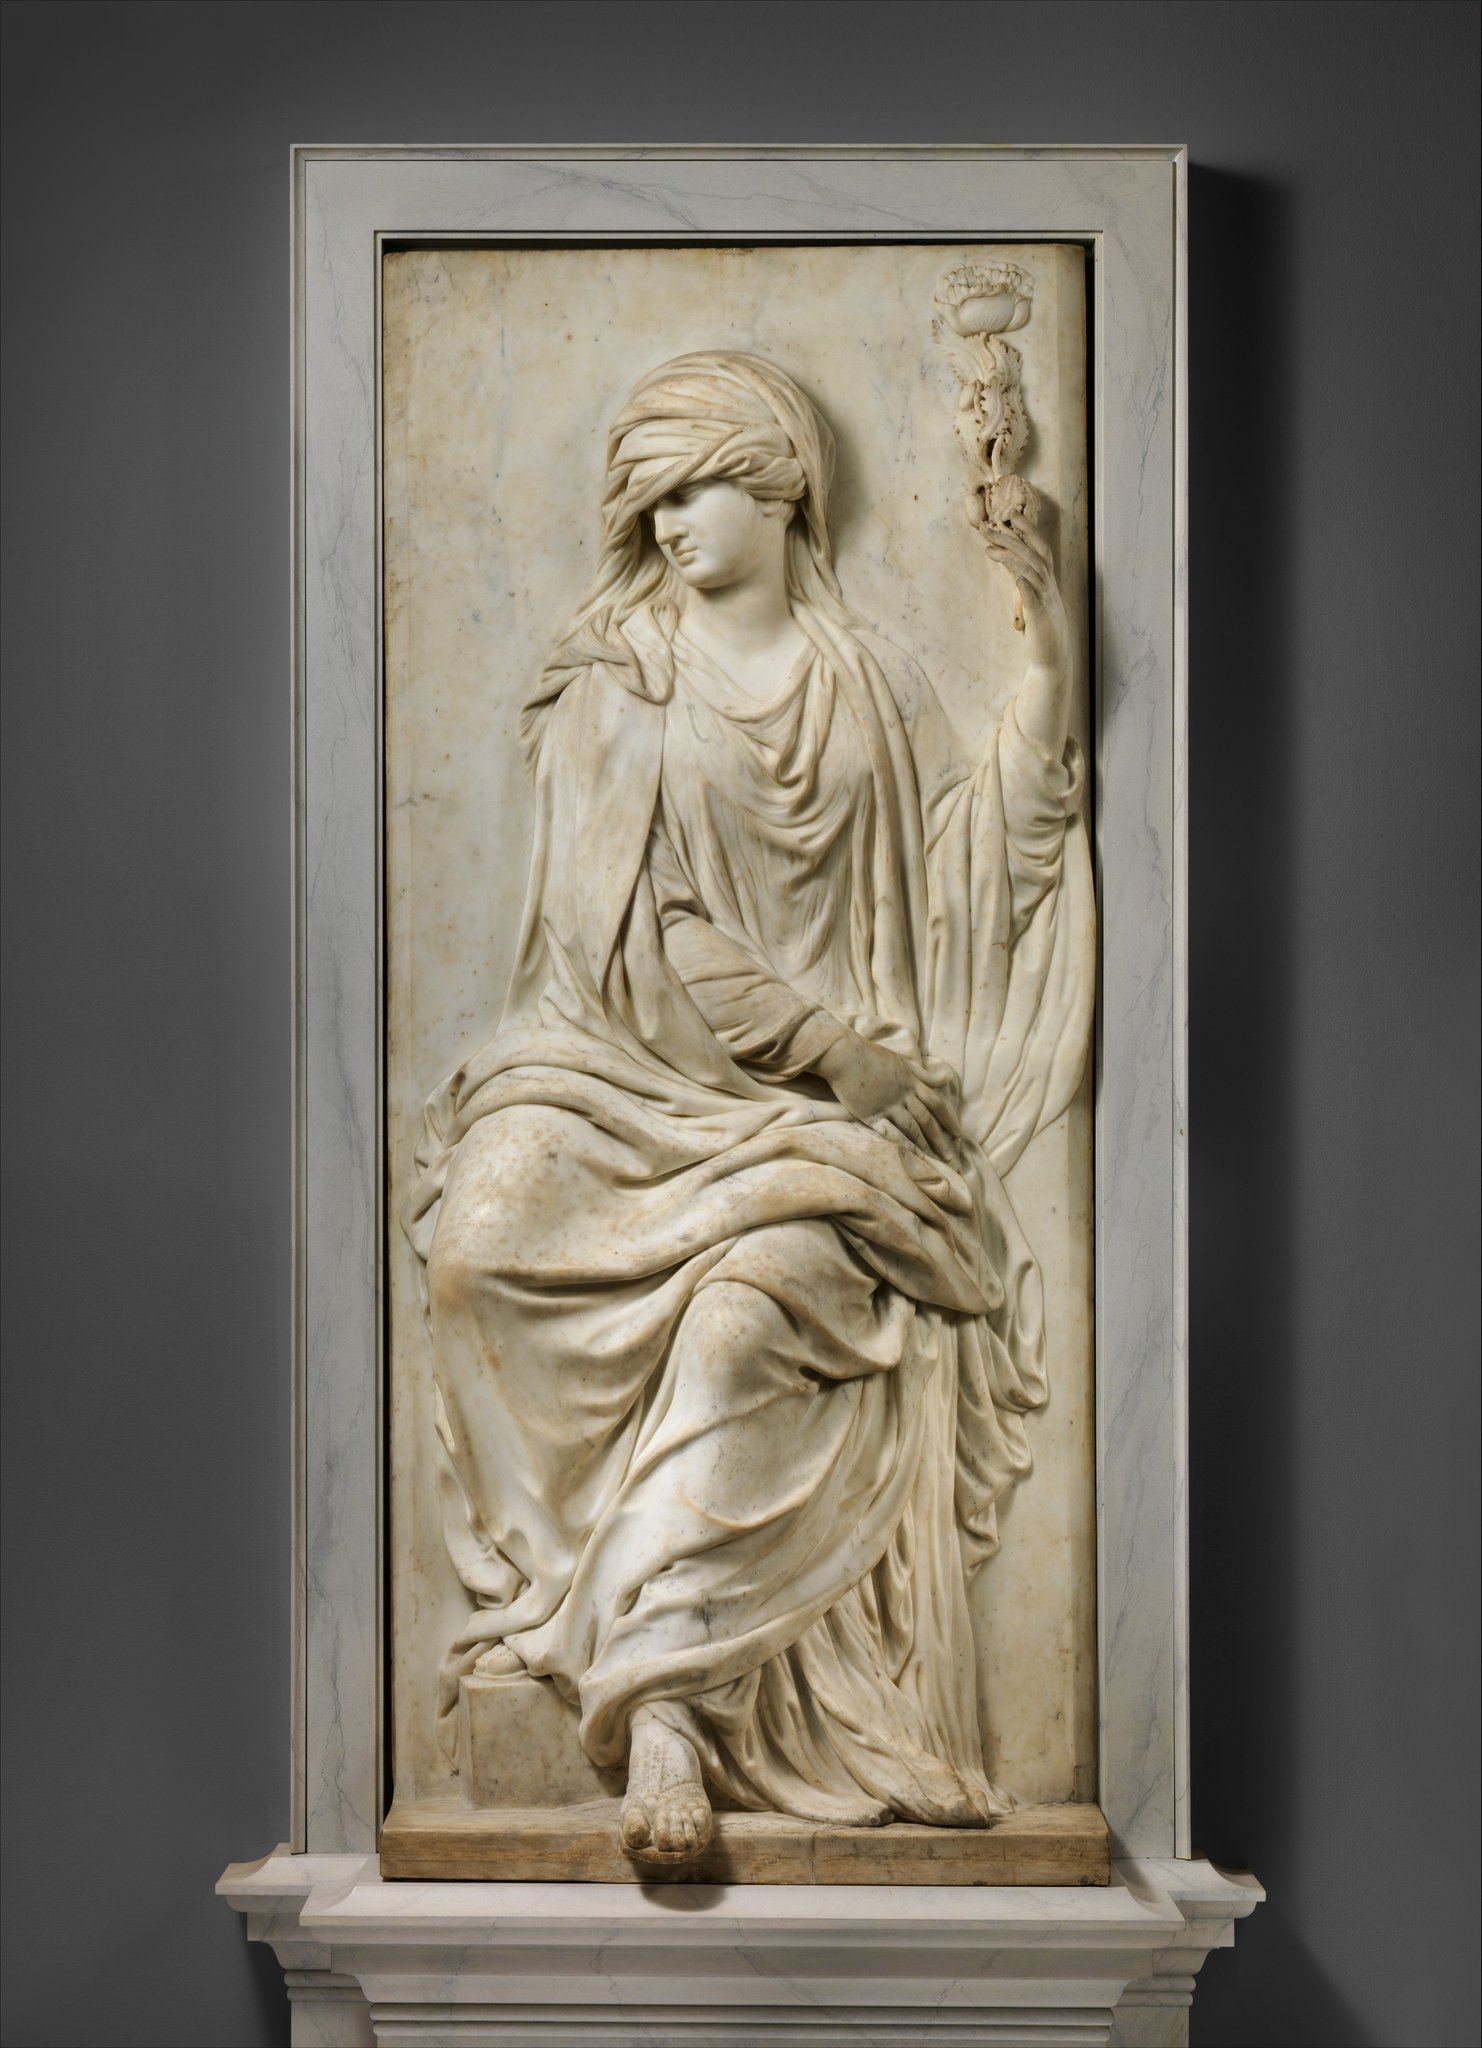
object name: relief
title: Allegorical figure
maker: françois girardon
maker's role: artist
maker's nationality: french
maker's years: 1628-1715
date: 1672-1675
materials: marble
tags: women,flowers